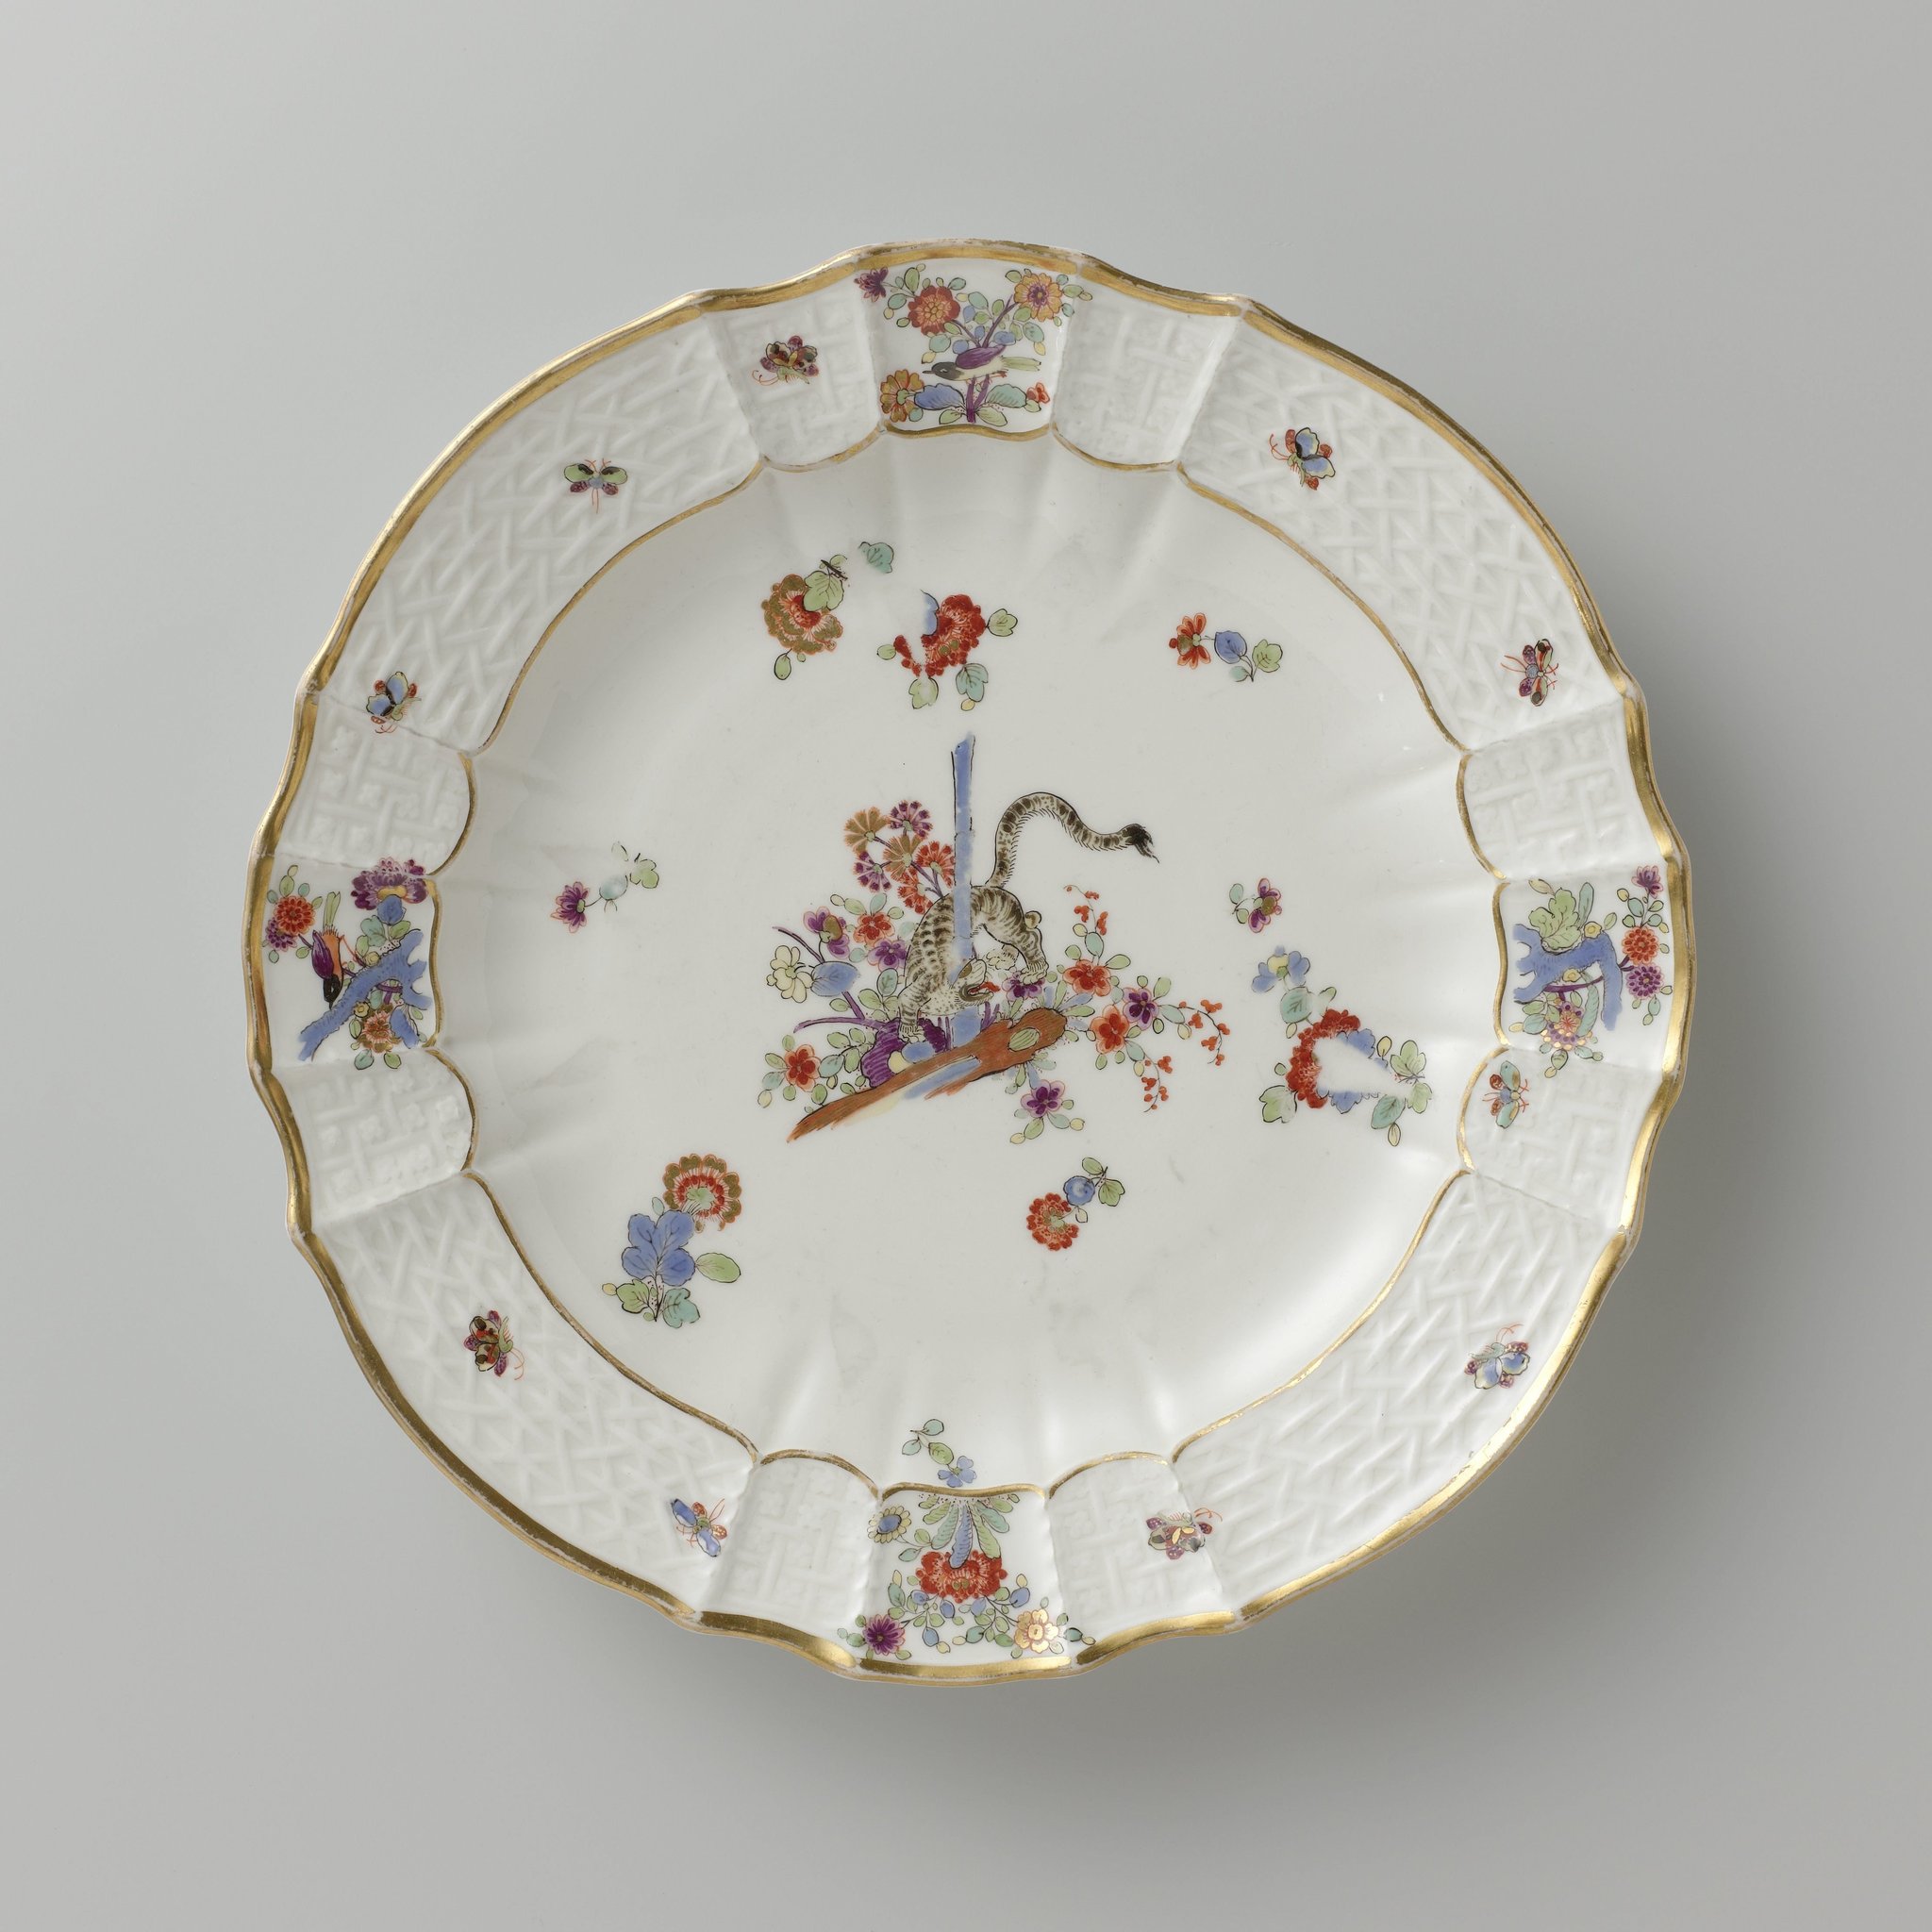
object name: eating drinking utensil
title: Rond bord, veelkleurig beschilderd met een Kakiemon-decor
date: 1740-1745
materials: porcelain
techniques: painted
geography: meissen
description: Rond bord van beschilderd porselein. Het bord is geribd en heeft een geschulpte rand. Het bord is beschilderd met een tijger die om een blauwe bamboestengel tussen bloemen is gedraaid, gestrooide Indianische Blumen, vlinders en takken waarop vogels. De rand is versierd met het 'Altbrandenstein'-patroon. Het bord is gemerkt.